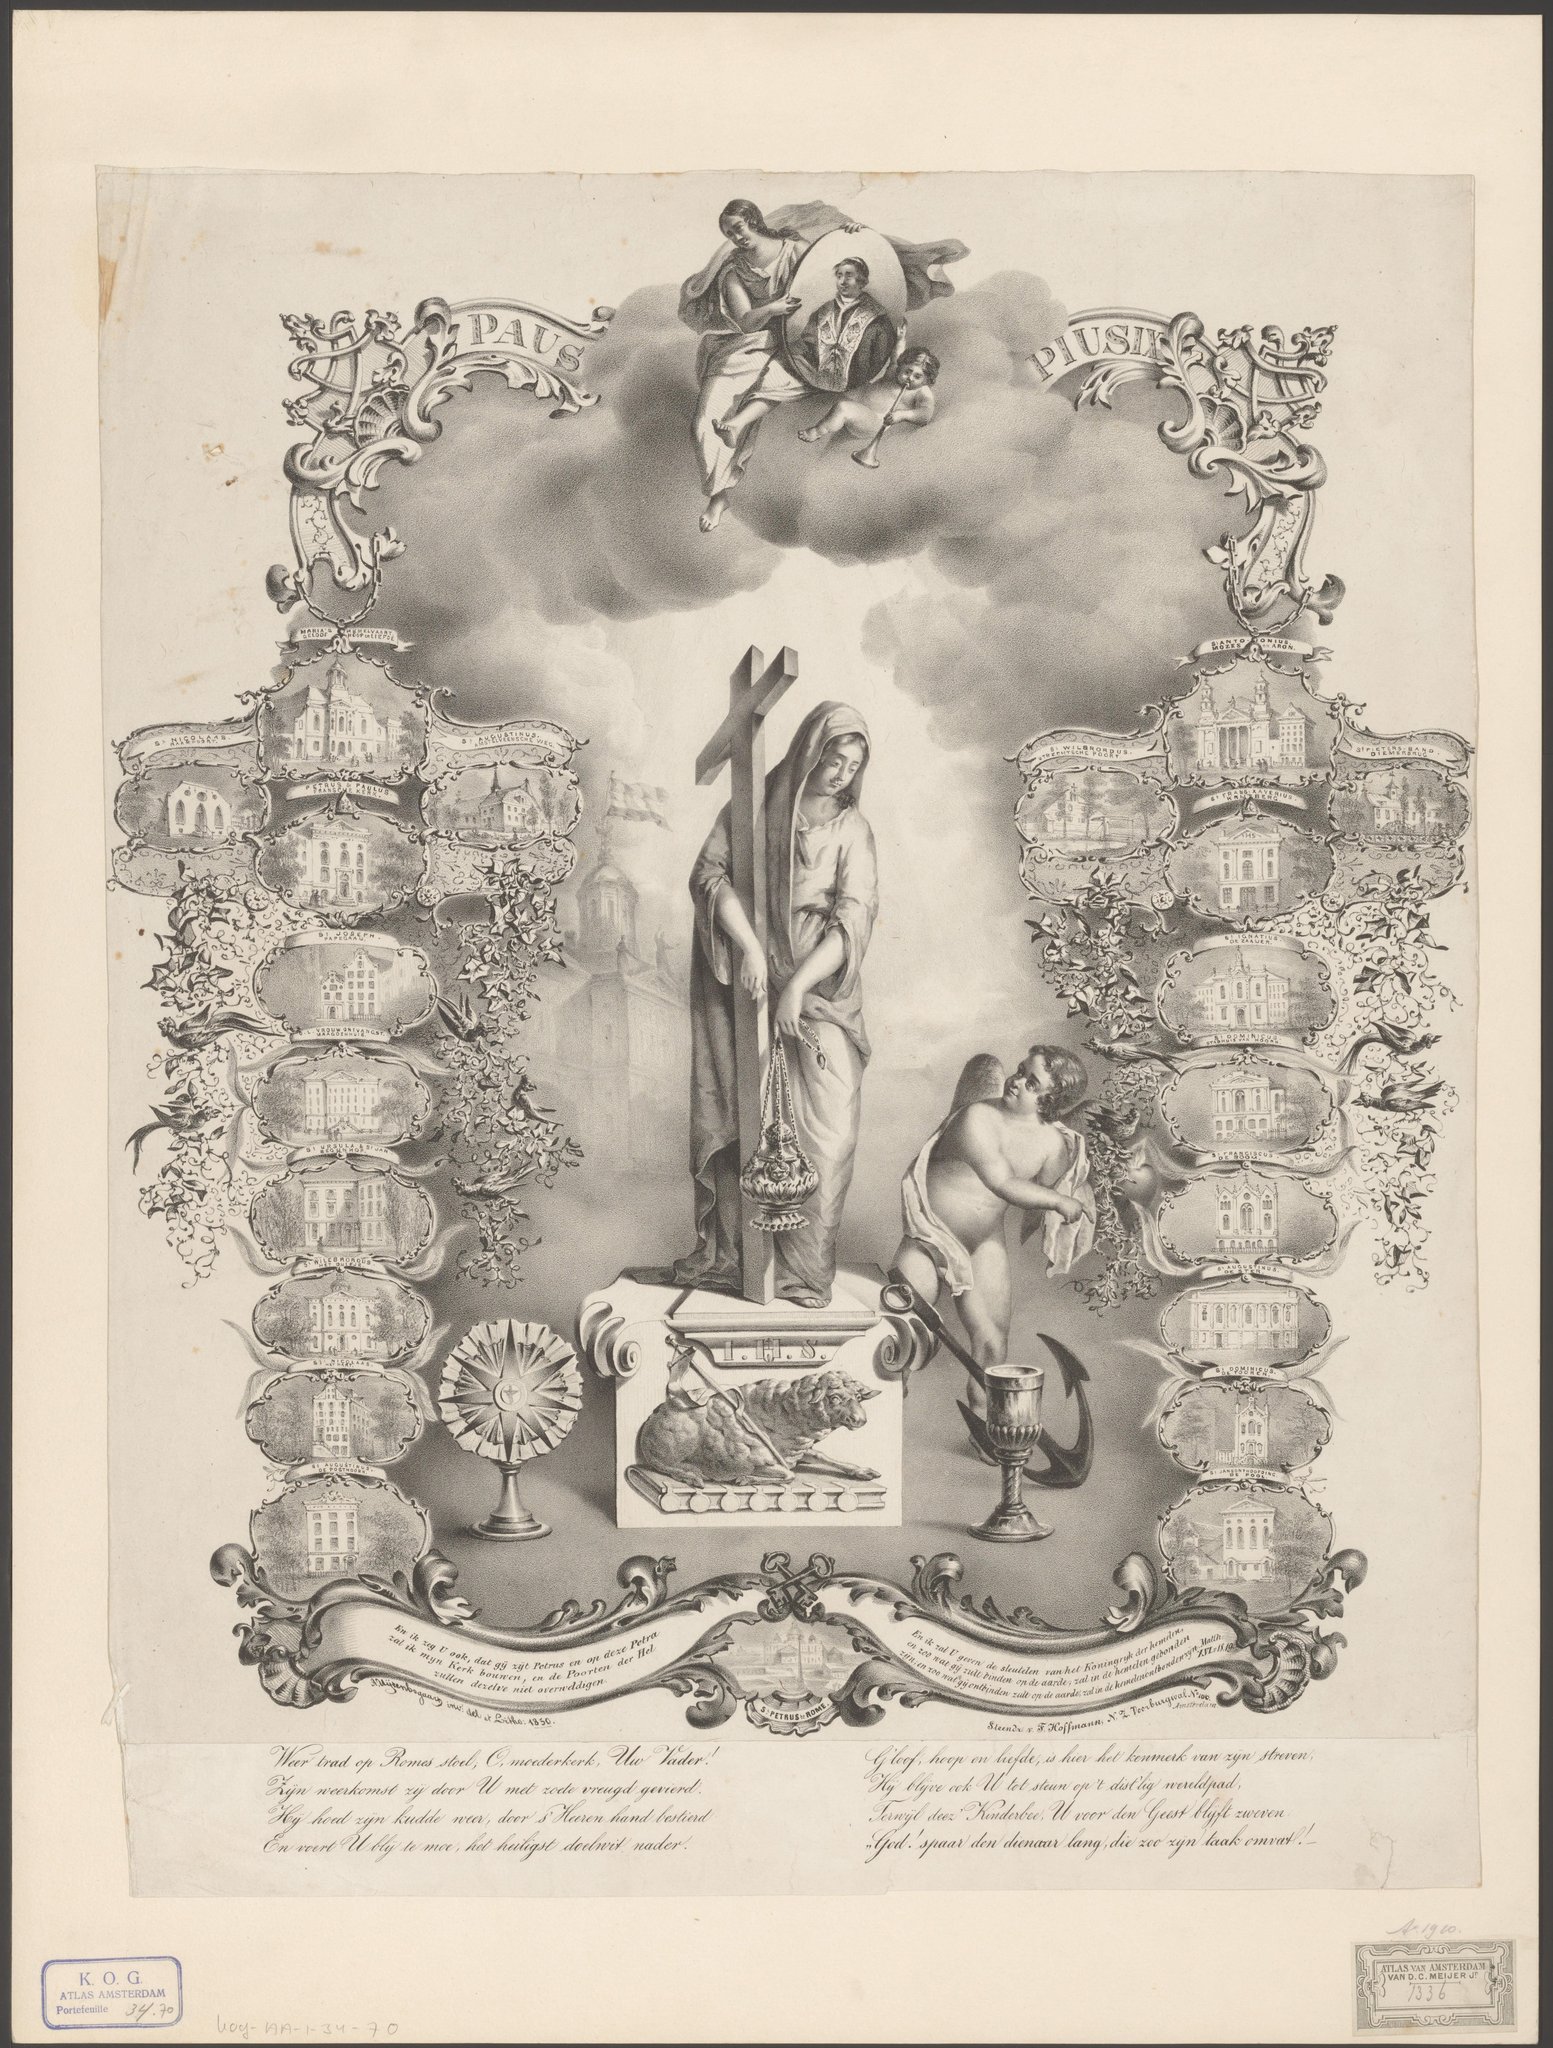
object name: print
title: Personificatie van Geloof omgeven door rooms-katholieke kerken te Amsterdam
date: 1850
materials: paper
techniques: lithograph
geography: netherlands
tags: rome, faith, 'fides'; 'fede', 'fede catholica', 'fede christiana', 'fede christiana catholica' (ripa) ~ one of the three theological virtues, church (exterior), parts of ship's exterior: anchor, cupids: 'amores', 'amoretti', 'putti'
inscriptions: collector's mark: Lugt 1811, collector's mark: Lugt 1641b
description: Onderwerpsrubriek binnen de Atlas Amsterdam: Kerkwezen: R.K. Gemeenten: Bestaande kerken, verzamelbladen.